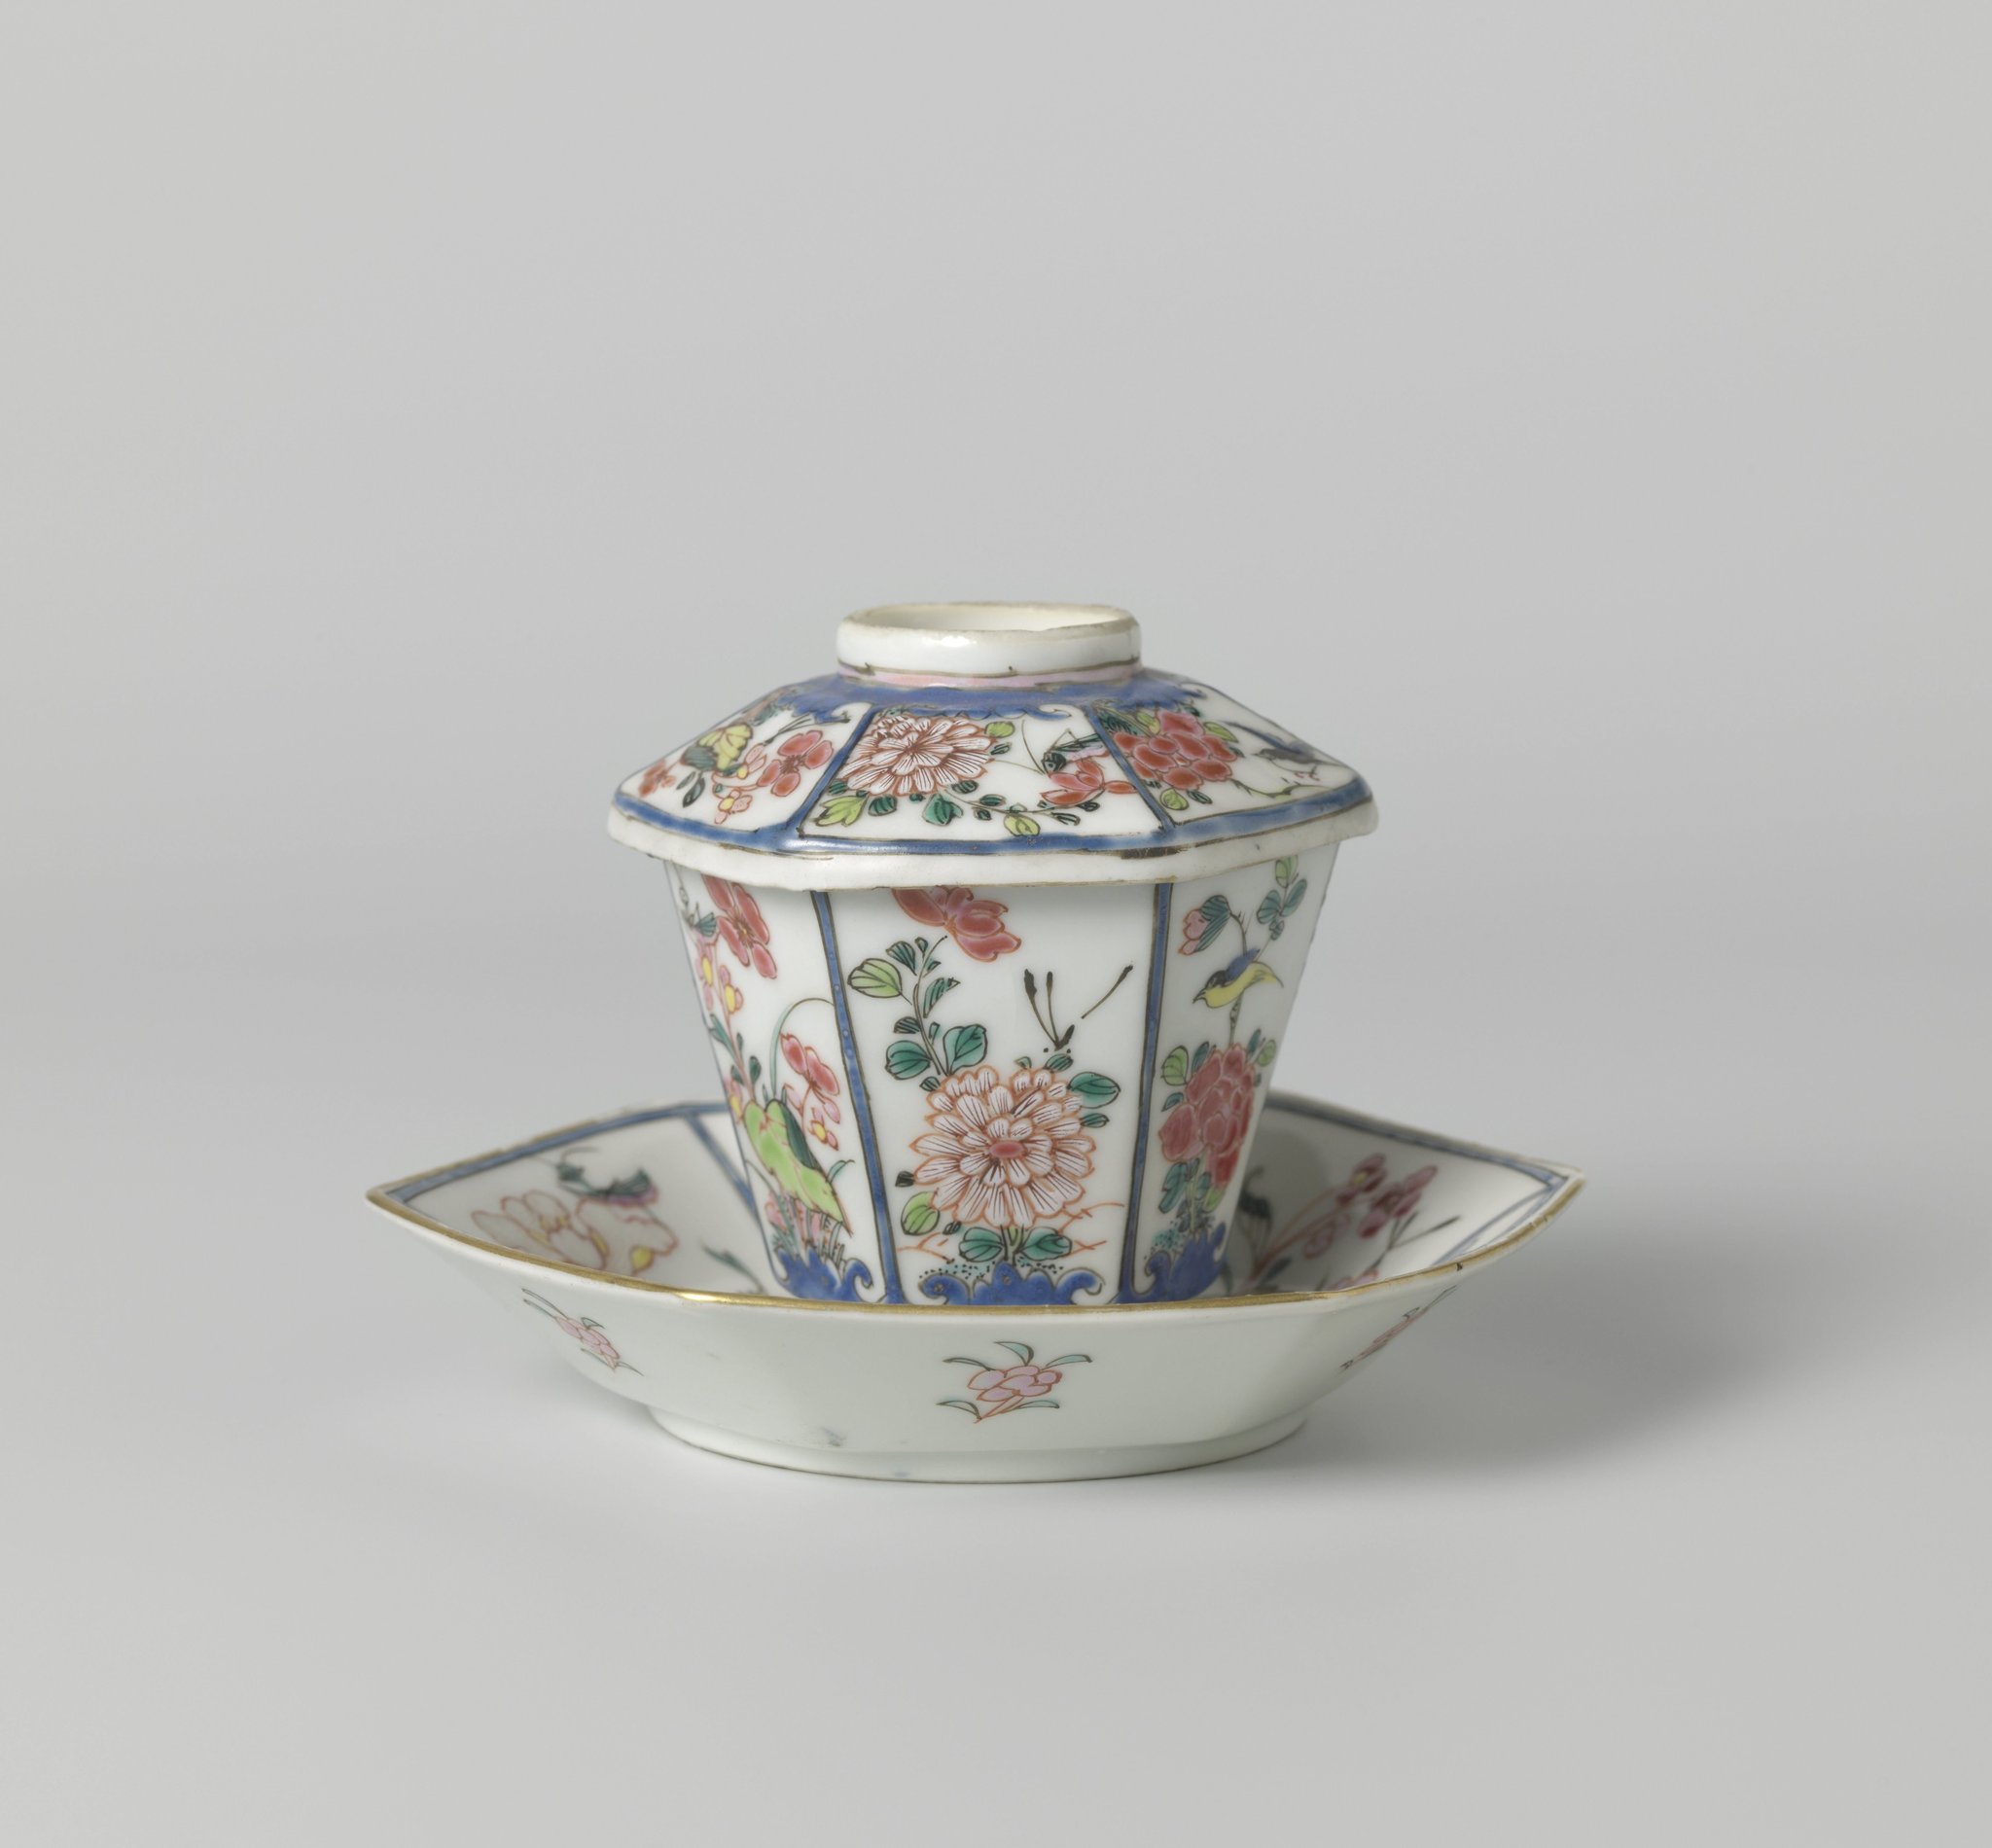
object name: kop en schotel, kop en schotel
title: Hexagonal, covered cup and saucer with flower sprays, birds and insects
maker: Anonymous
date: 1725-1749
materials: glaze, gold, paint, porcelain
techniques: firing, forming, gilding, turning, vitrification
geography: china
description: Kop en schotel, achtkantig versierd in vakken met vogels en bloemen in famille rose kleuren.